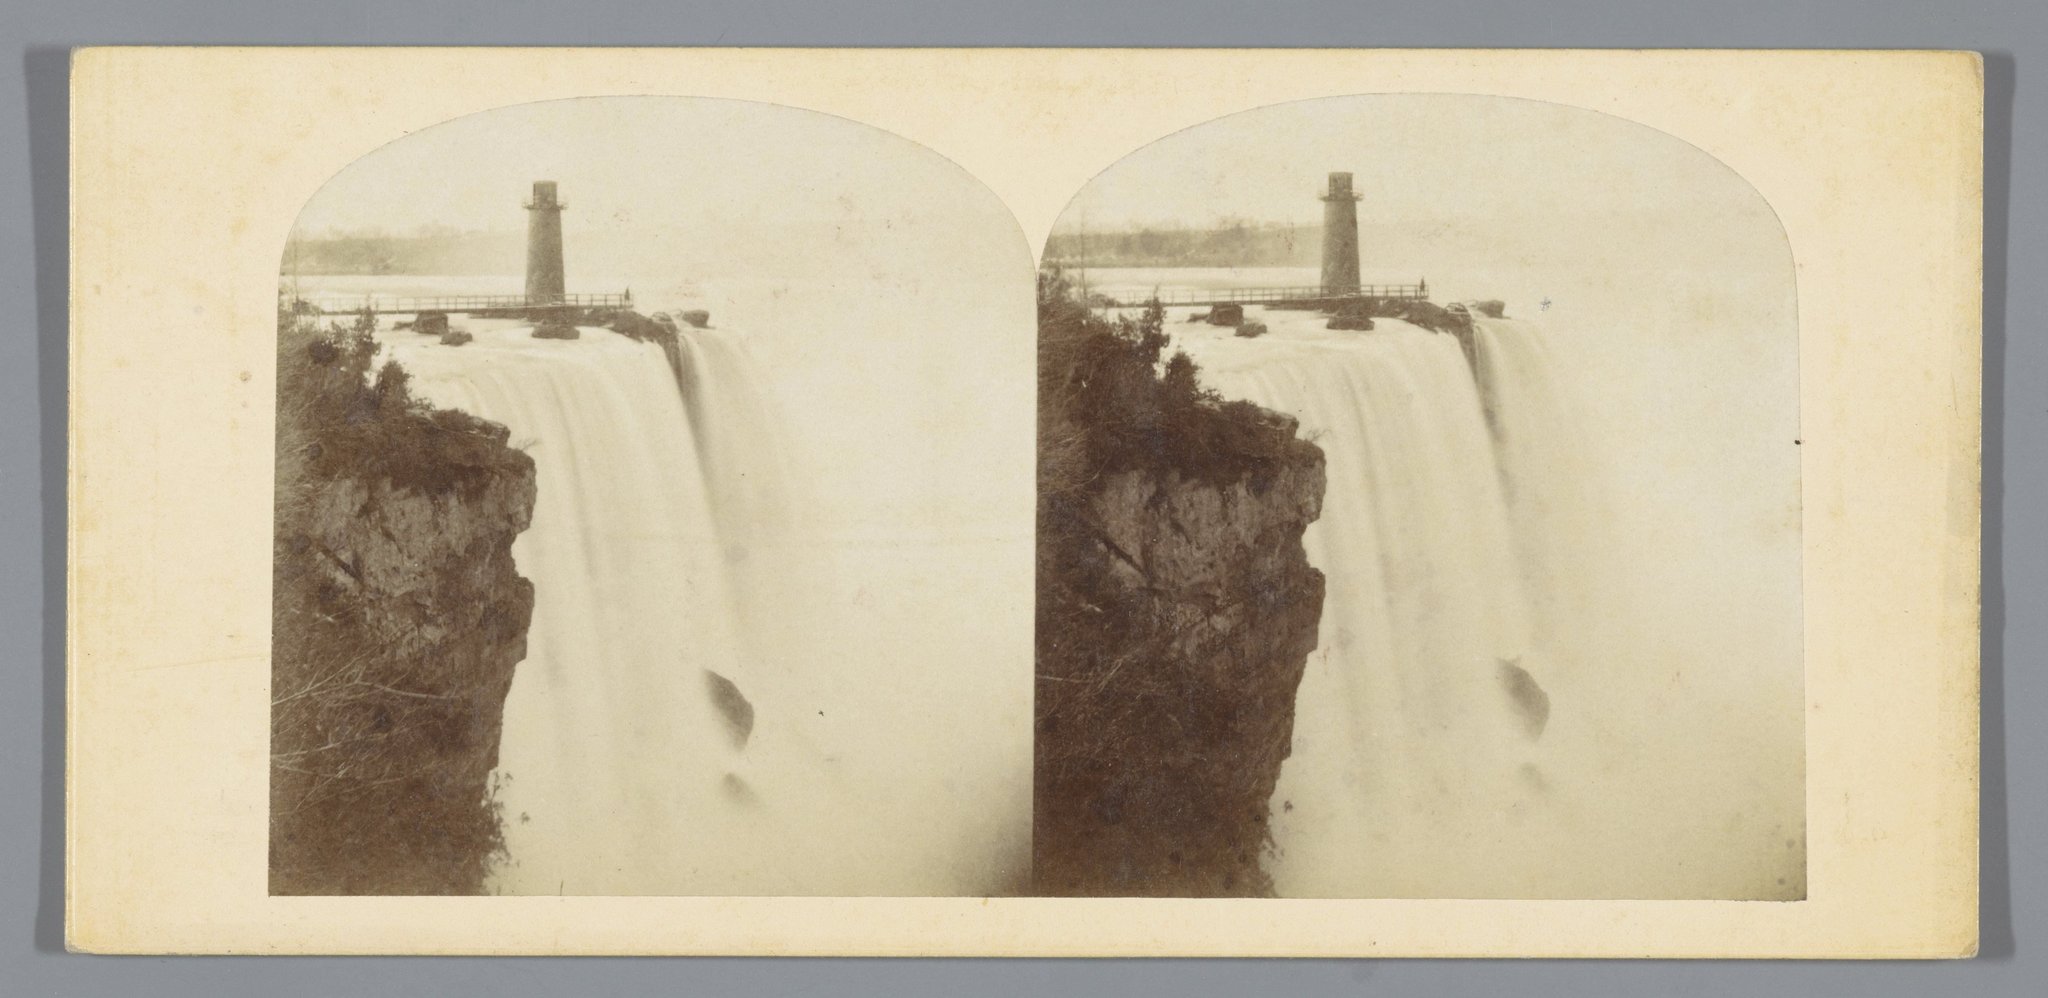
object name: stereograph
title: Horseshoe Falls en Terrapin Tower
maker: william england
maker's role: fotograaf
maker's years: 1816-1896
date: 1859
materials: cardboard, paper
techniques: albumen print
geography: horseshoe falls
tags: waterfall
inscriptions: : ‘"The sight (...) vent." Byron’